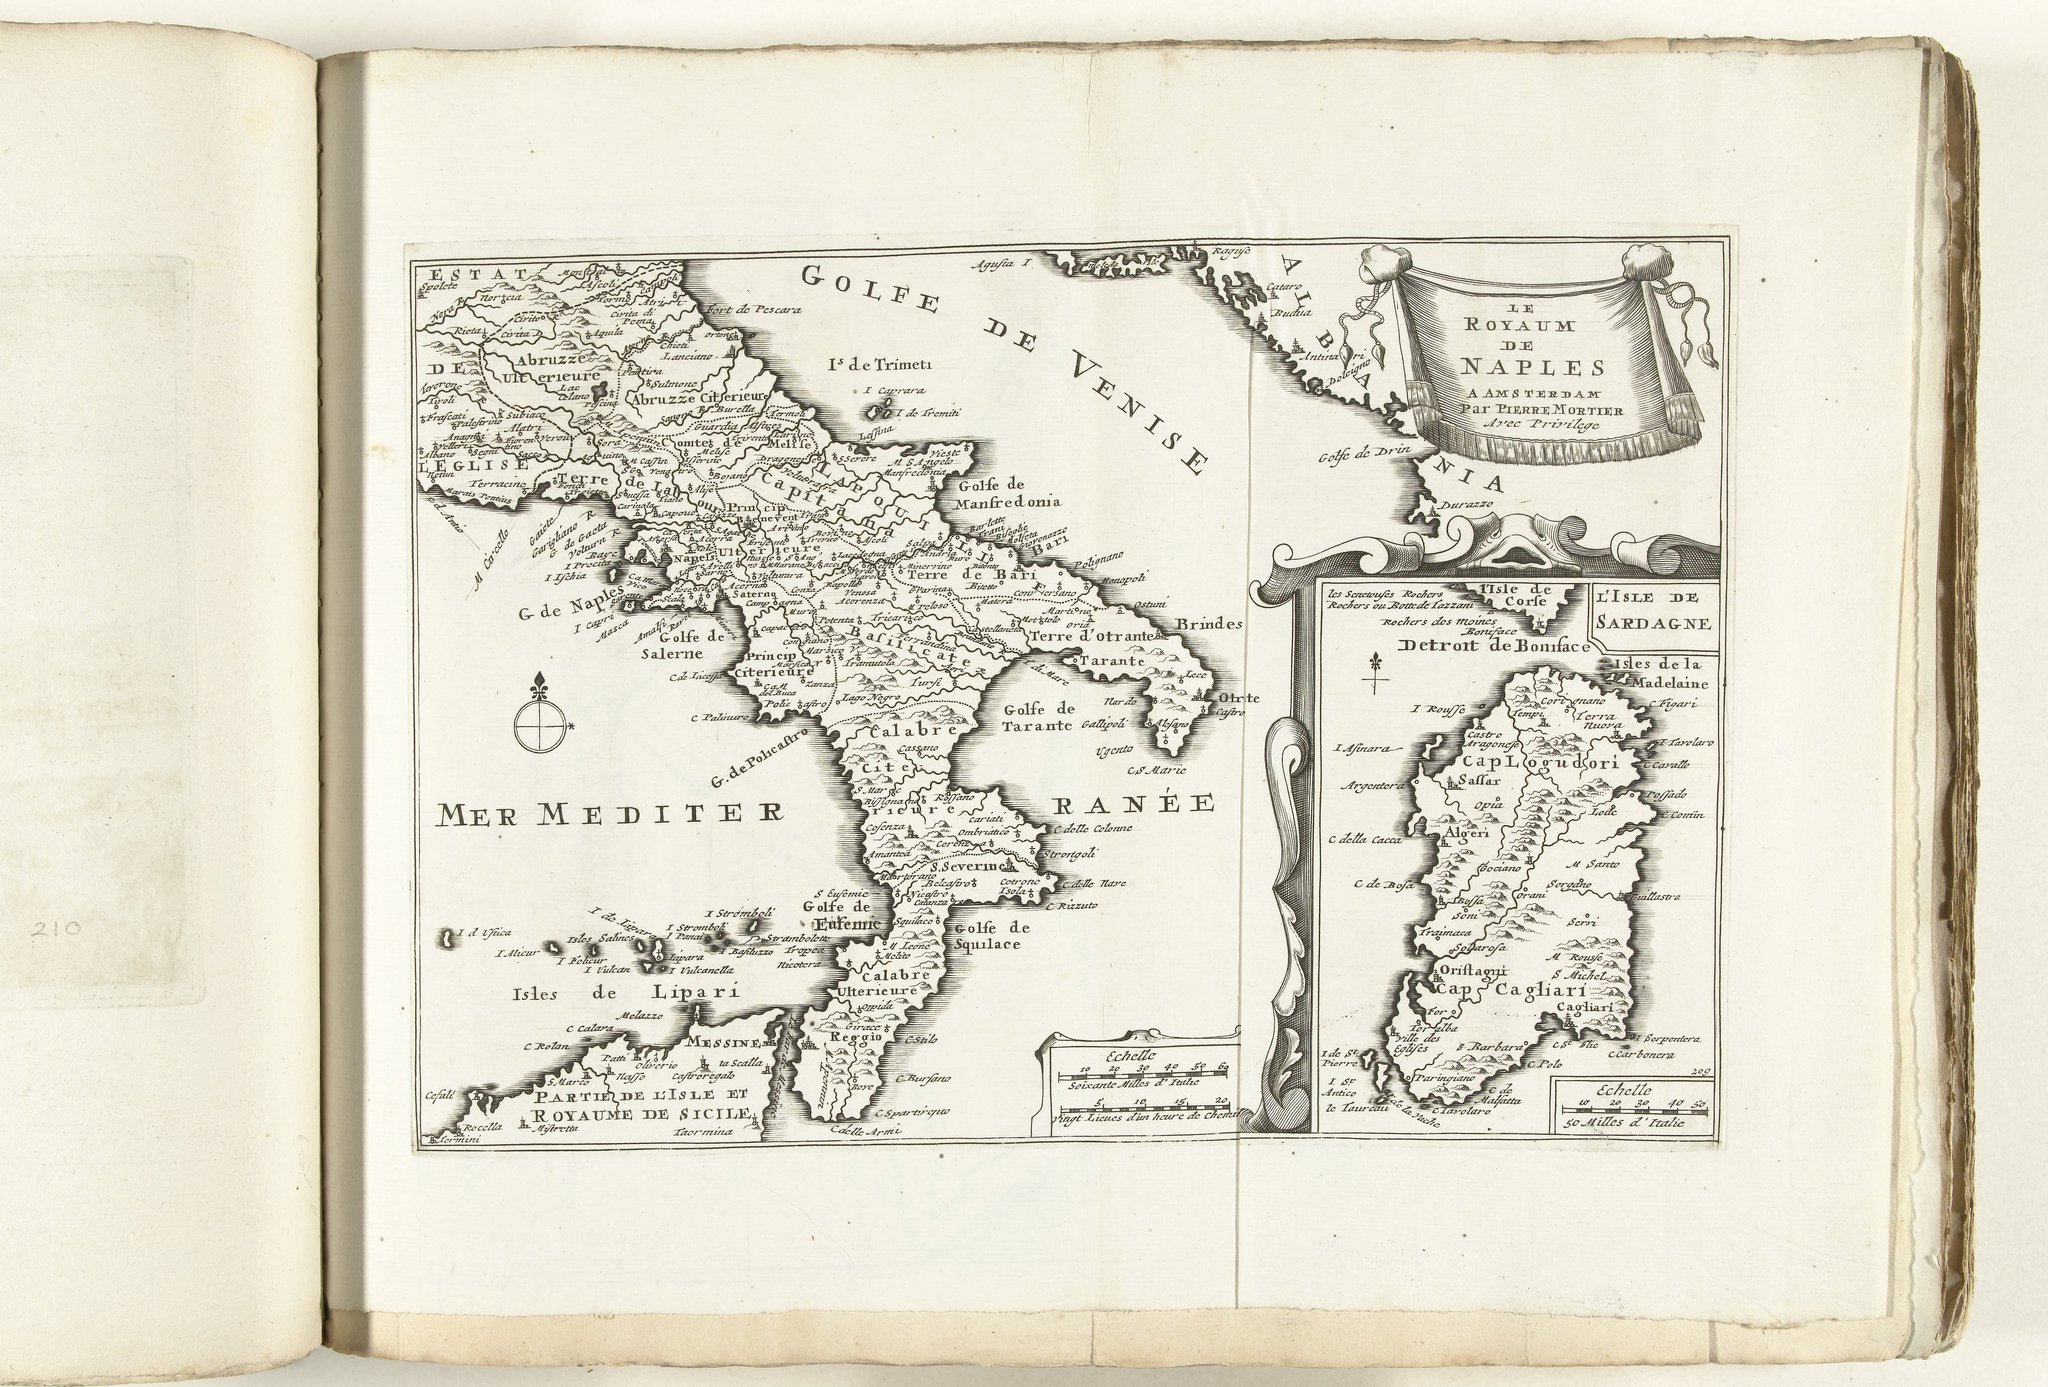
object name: map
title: Les Forces de l'Europe, Asie, Afrique et Amerique, ou description des principales villes avec leurs fortifications. Dessignées par les meilleurs ingenieurs, particulierement celles qui sont sous la domination de la France (...) et ornées de plusieurs superbes edifices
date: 1702-1703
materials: paper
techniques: engraving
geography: northern netherlands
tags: maps of separate countries or regions, naples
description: Kaart van het koninkrijk Napels, met een inzet met een kaart van Sardinië. Plaat nr. 209 in het prentwerk bestaande in totaal uit 276 genummerde platen van vermaarde sterke steden en vestingen in het kader van de Spaanse Successieoorlog. Voor het merendeel zijn deze platen gekopieerd naar de anonieme Franse platen: in Les forces de l'Europe en in: Le theatre de la guerre, dans les Pays-Bas, beide oorspronkelijk uitgegeven door Nicolas de Fer te Parijs (1693-1697) in het kader van de Negenjarige Oorlog. Titel en opschriften in de plaat in het Frans.